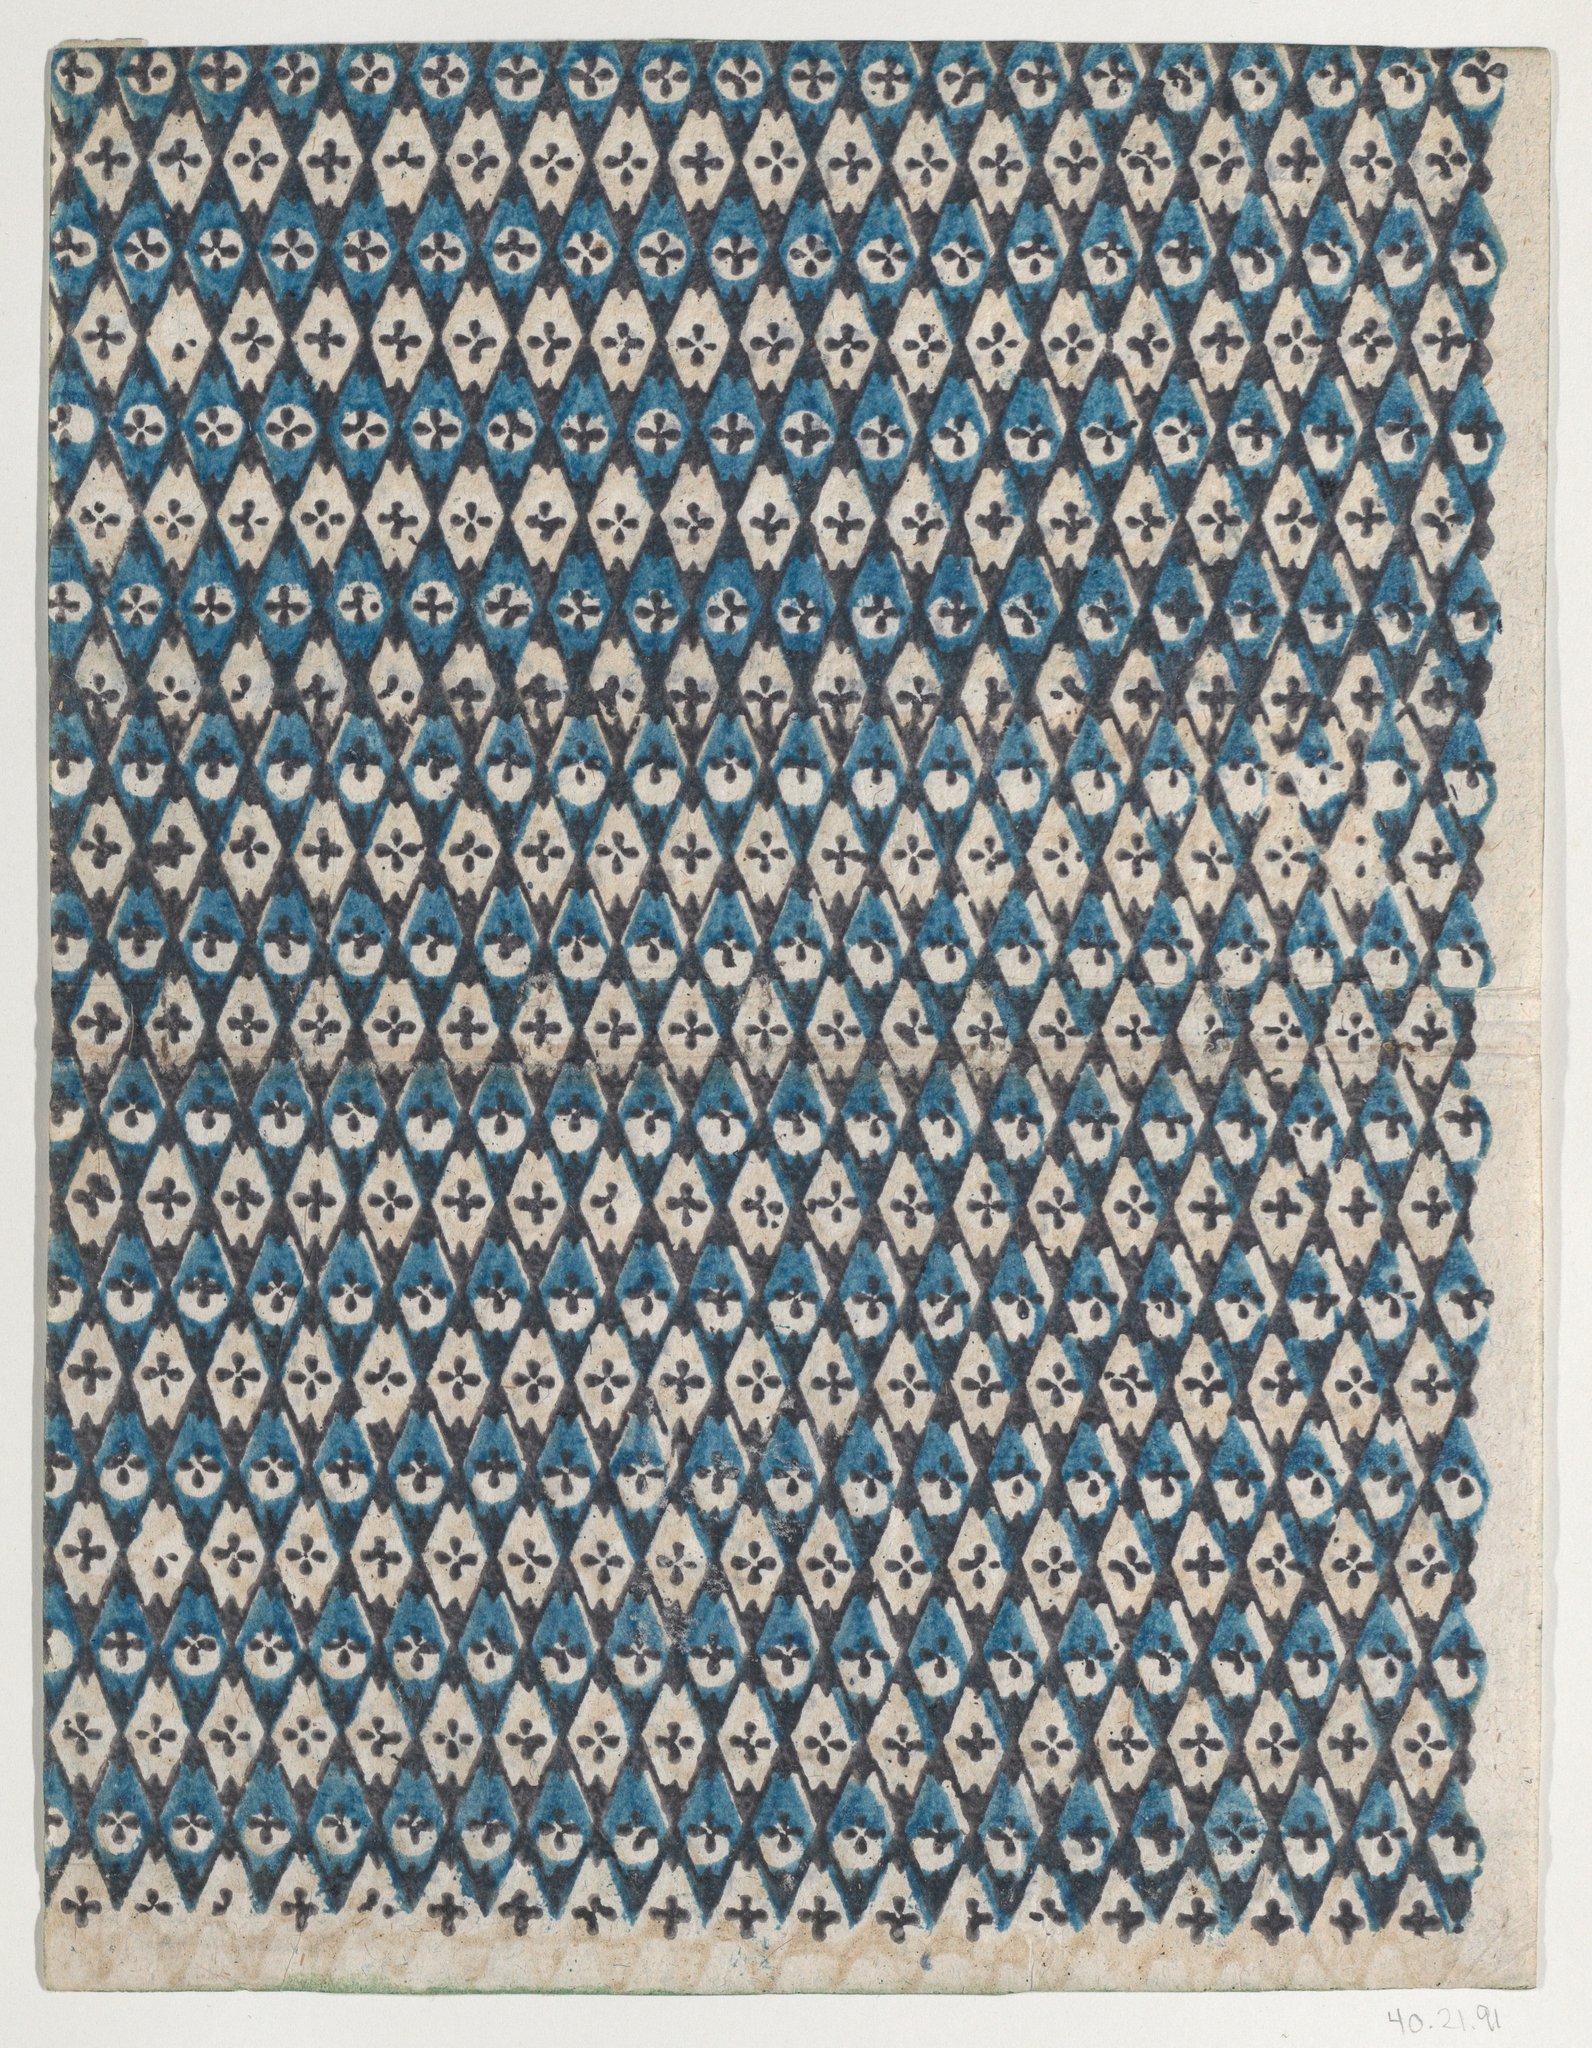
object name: print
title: Sheet with overall diamond pattern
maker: Anonymous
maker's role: artist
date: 1767-1866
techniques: relief print